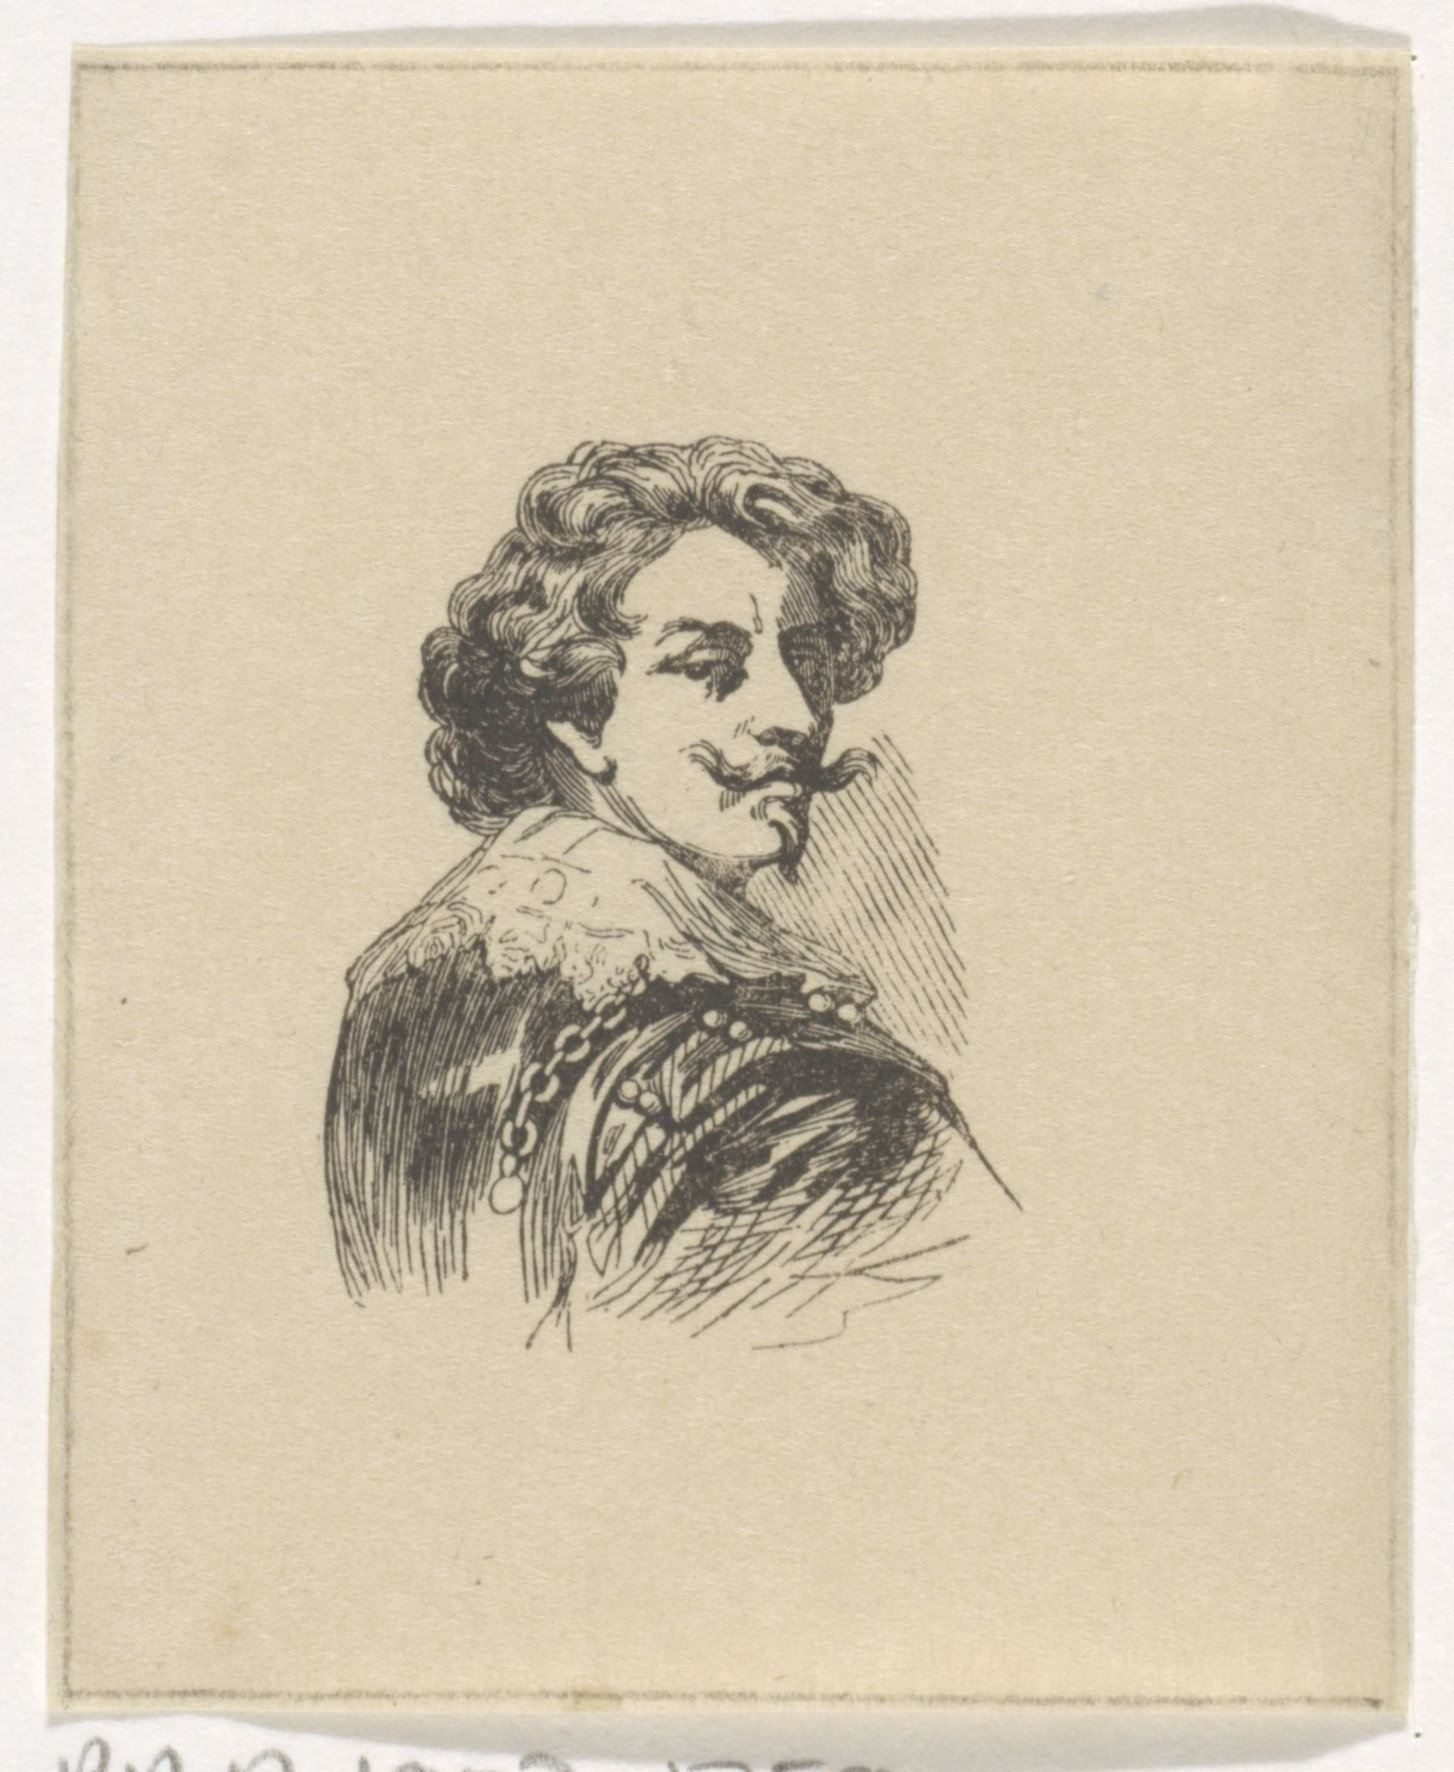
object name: book illustration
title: Portret van een kunstenaar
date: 1842-1843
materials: paper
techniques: engraving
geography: netherlands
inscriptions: collector's mark: Lugt 2228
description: Prent uit: Immerzeel, Johannes. De levens en werken der Hollandsche en Vlaamsche kunstschilders, beeldhouwers, graveurs en bouwmeesters : van het begin der vijftiende eeuw tot heden. Amsterdam: J.C. van Kesteren, 1842-1843.